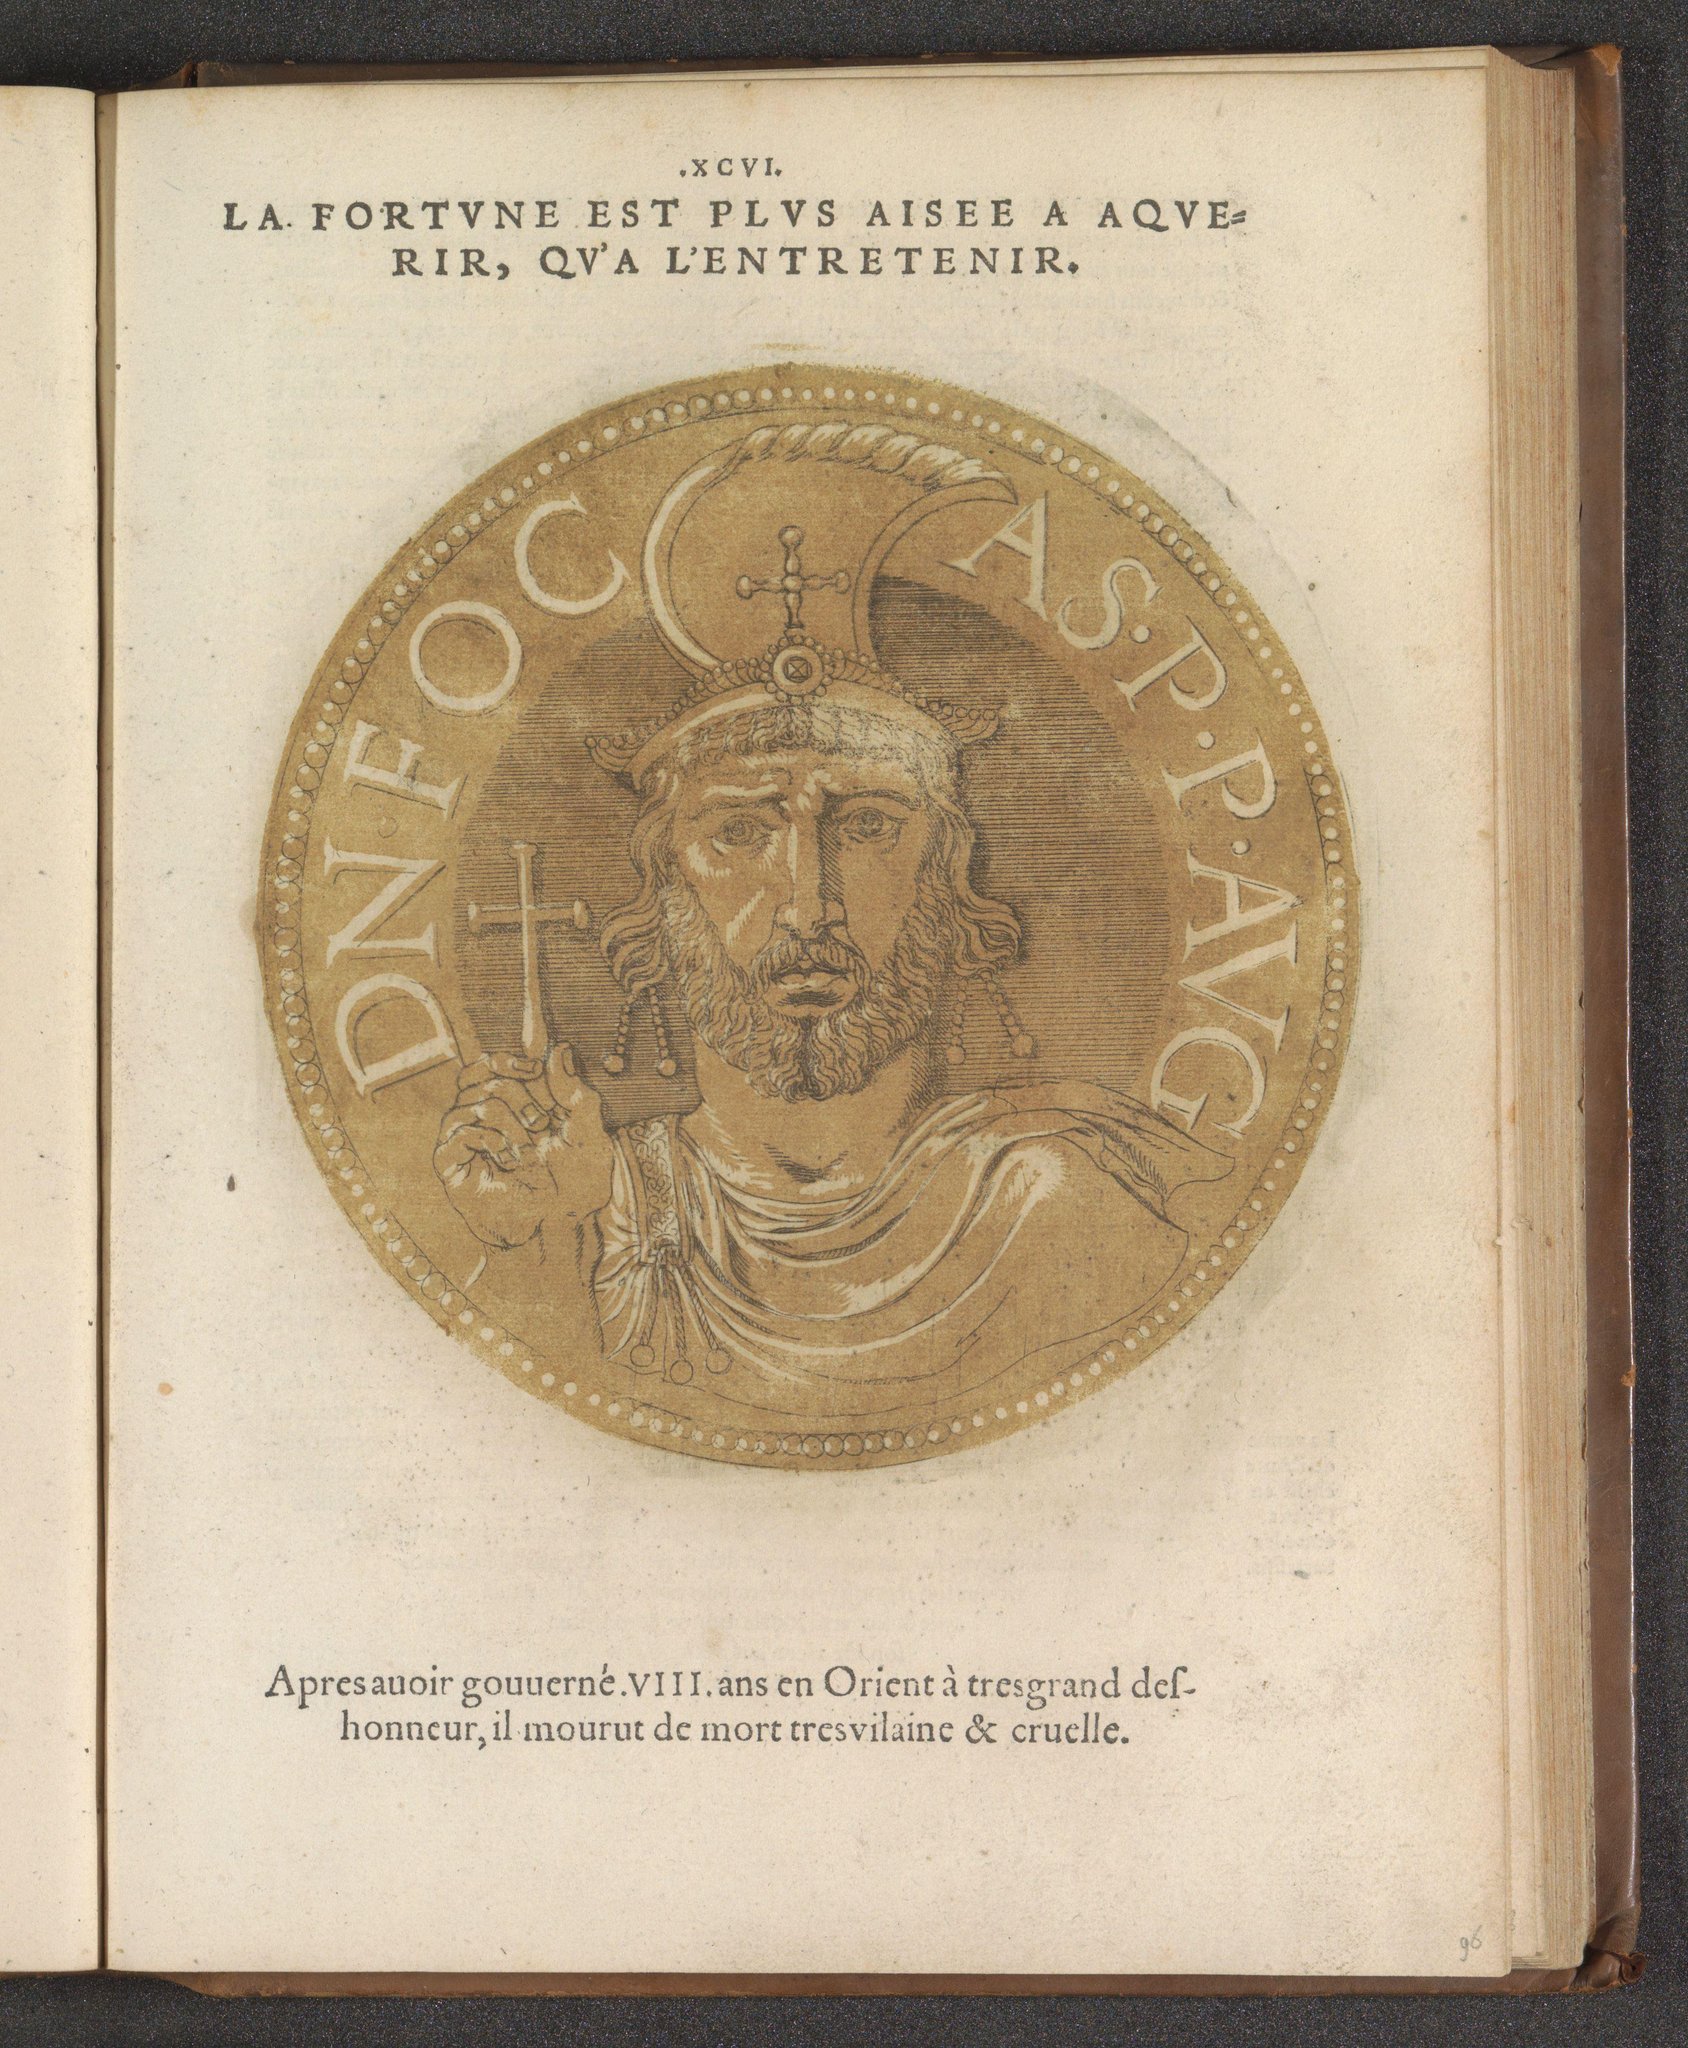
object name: page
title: Les images presque de tous les empereurs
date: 1557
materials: paper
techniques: woodcut, etching, letterpress printing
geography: antwerp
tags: emperor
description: Portret van keizer Phocas, op een munt met randschrift. De prent maakt deel uit van een boek over de keizers vanaf Julius Caesar tot en met Karel V en zijn broer Ferdinand.